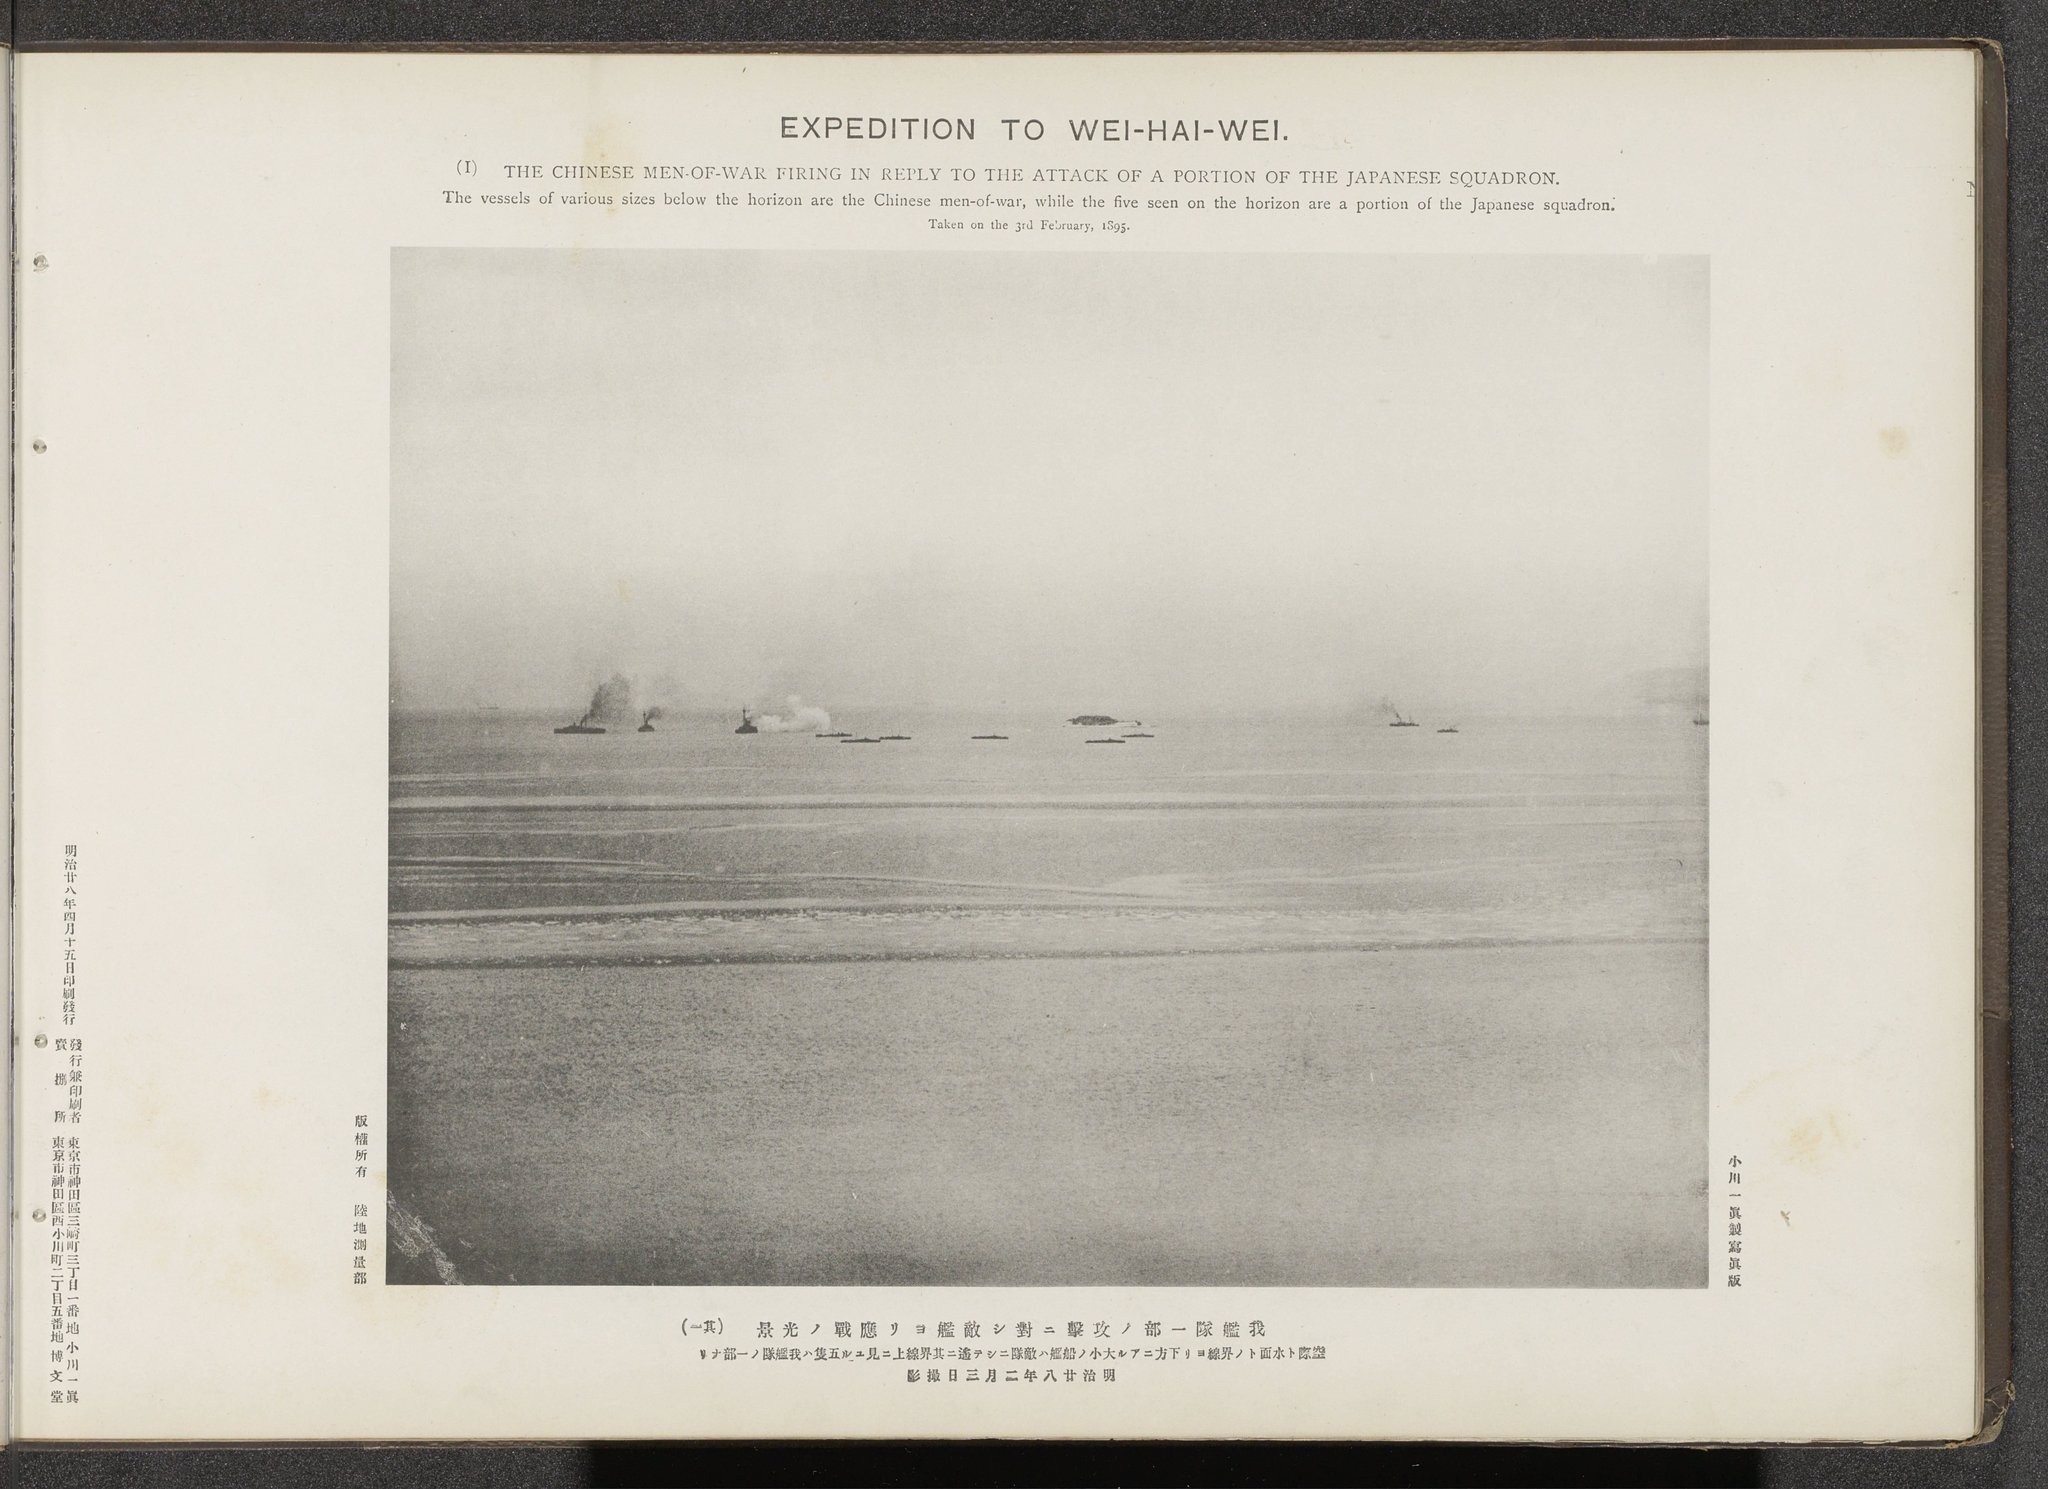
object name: page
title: The Chinese men-of-war firing in reply to the attack of a portion of the Japanese squadron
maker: kazumasa ogawa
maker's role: auteur, fotograaf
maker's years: 1860-1929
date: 1895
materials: paper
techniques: photograph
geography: shandong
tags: ships (in general), sea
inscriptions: inscription: ‘The vessels of various sizes (...) on the horizon are a portion of the Japanese squadron.’, inscription: ‘Expedition to Wei-Hai-Wei.’